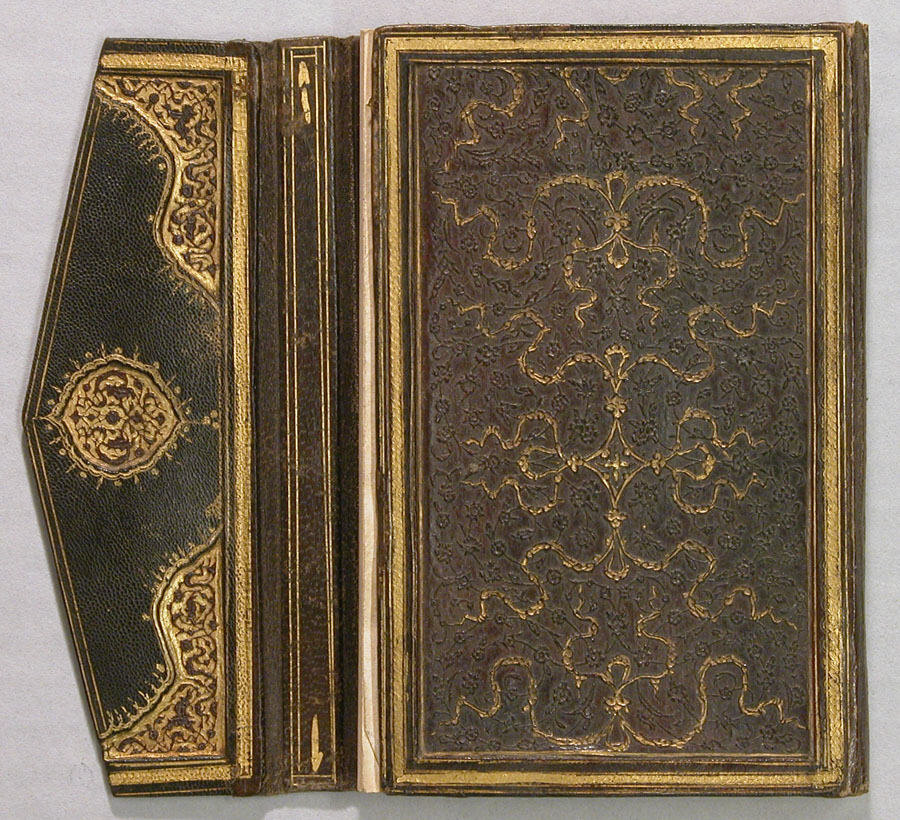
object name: bookbinding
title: Bookbinding (Jild-i kitab)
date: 1401-1500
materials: leather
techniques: gilding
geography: iran